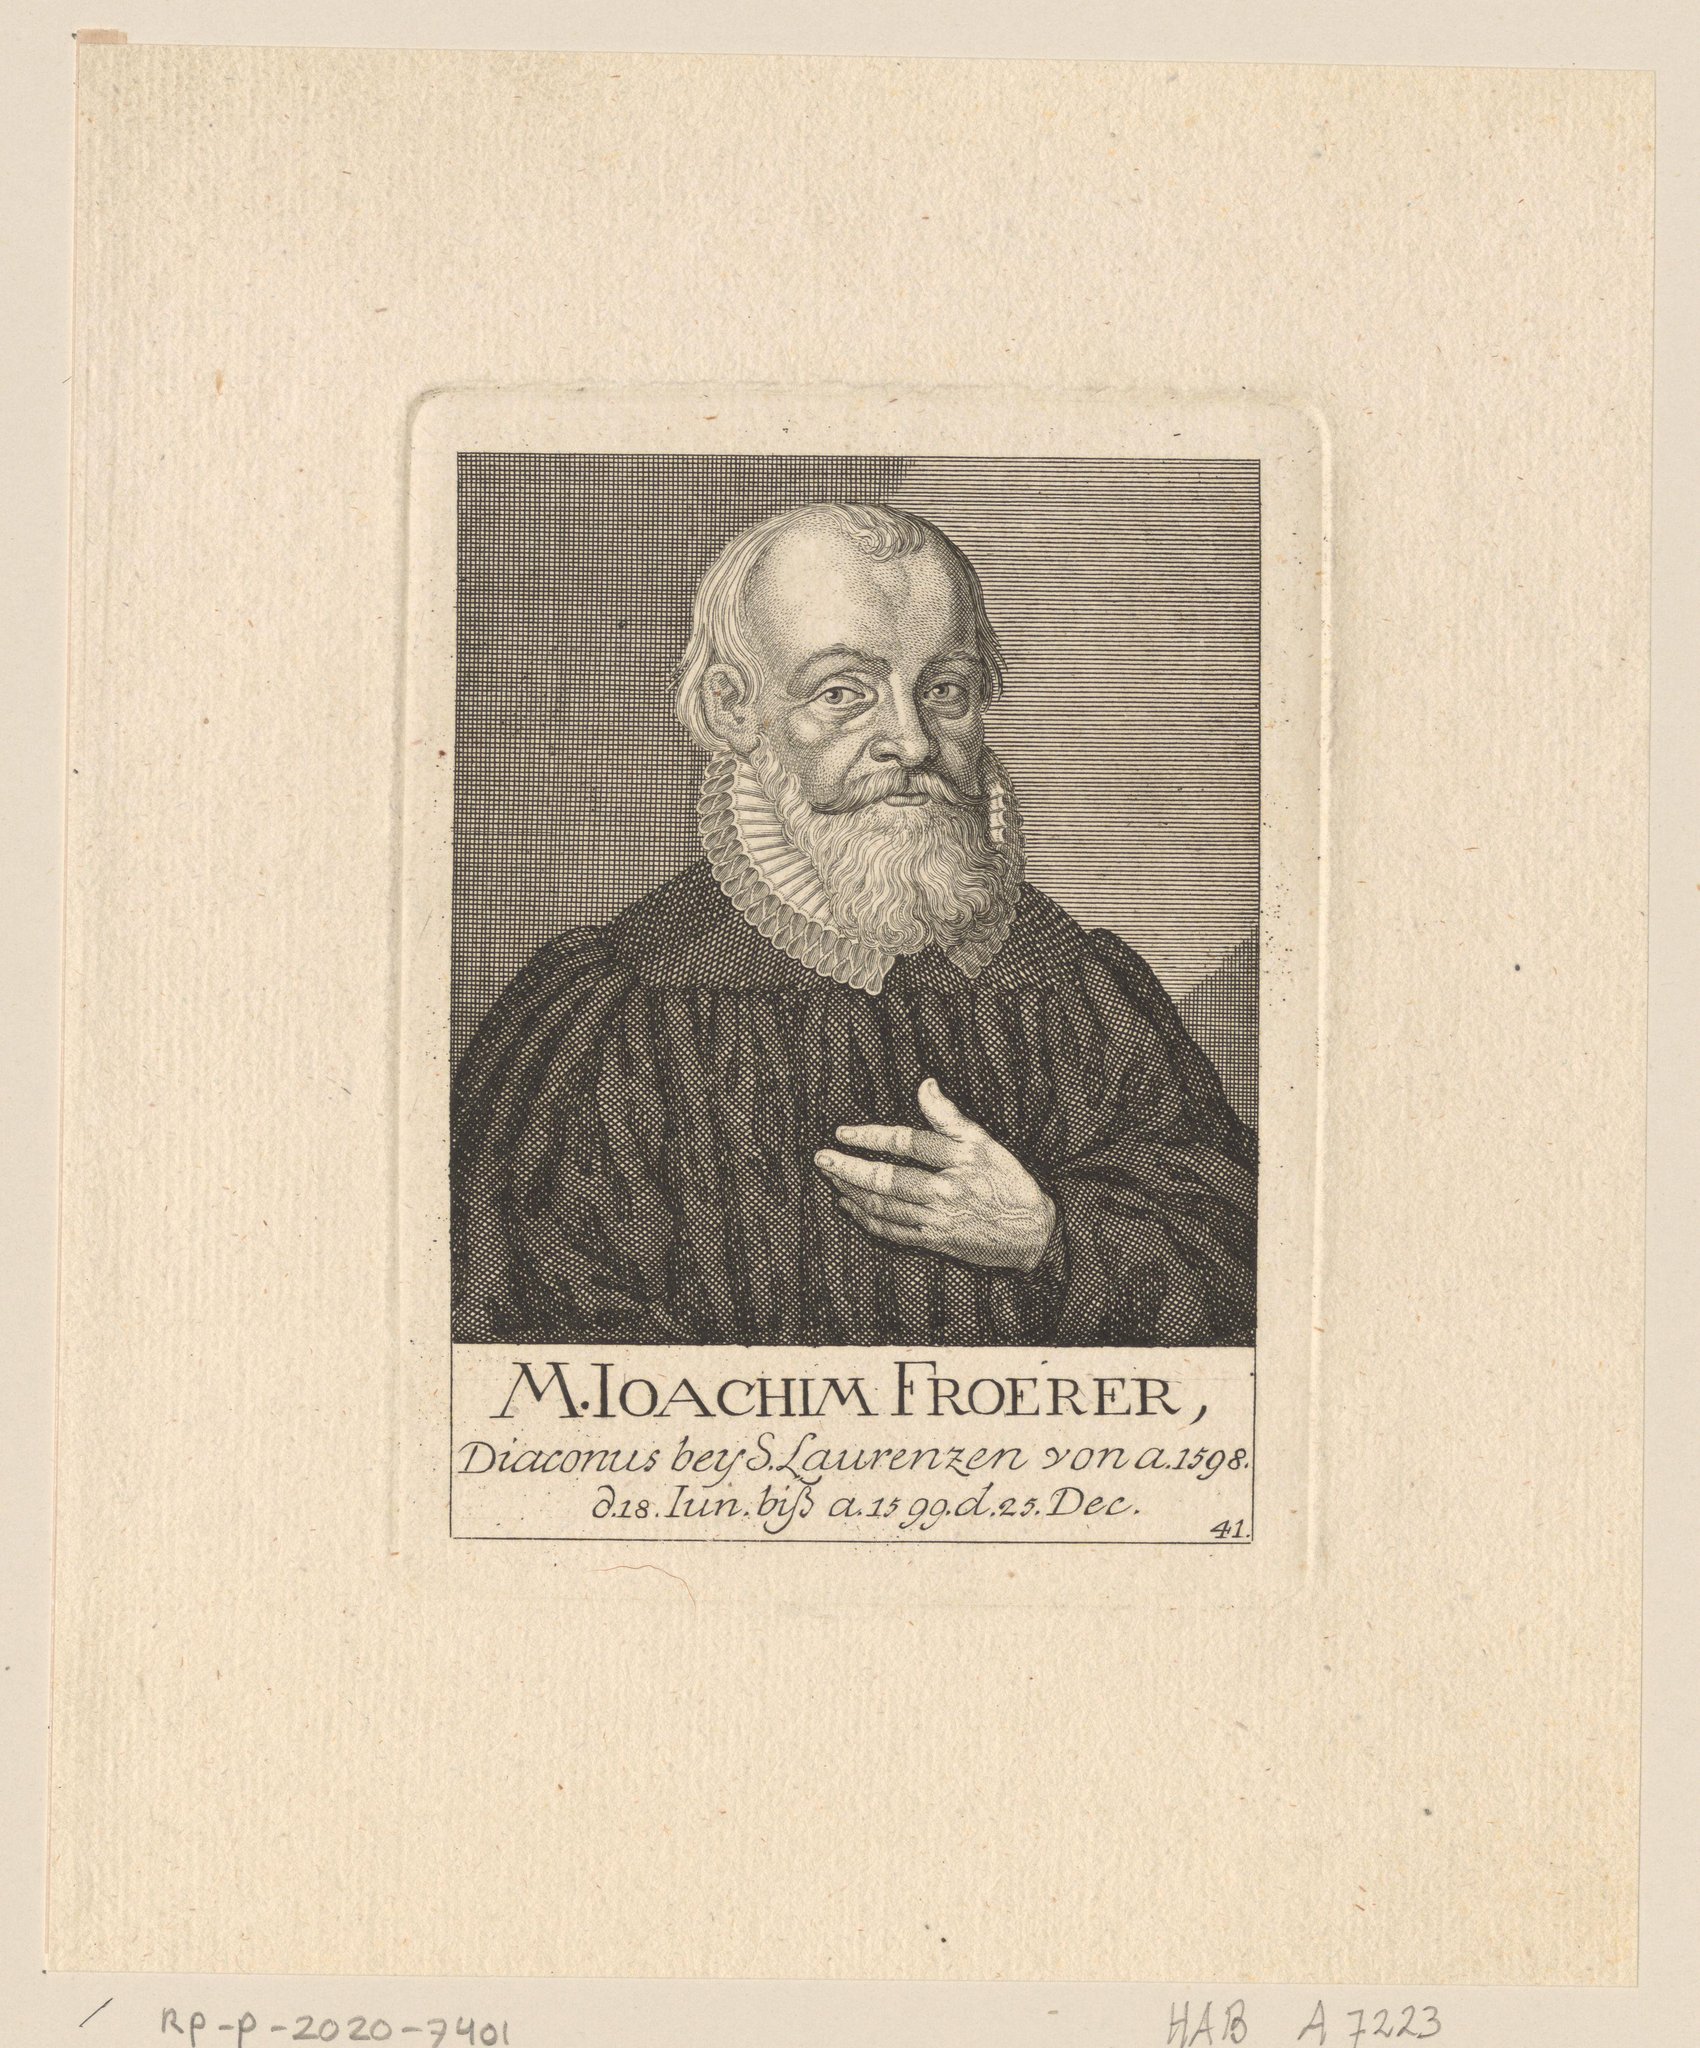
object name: print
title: Portret van Joachim Frörer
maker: Anonymous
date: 1756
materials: paper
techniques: engraving, etching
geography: germany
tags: historical persons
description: Prent waarschijnlijk uit: Würfel, Andreas. Diptycha ecclesiae Laurentianae (...). Neurenberg: Christoph Melchior Roth, 1756.